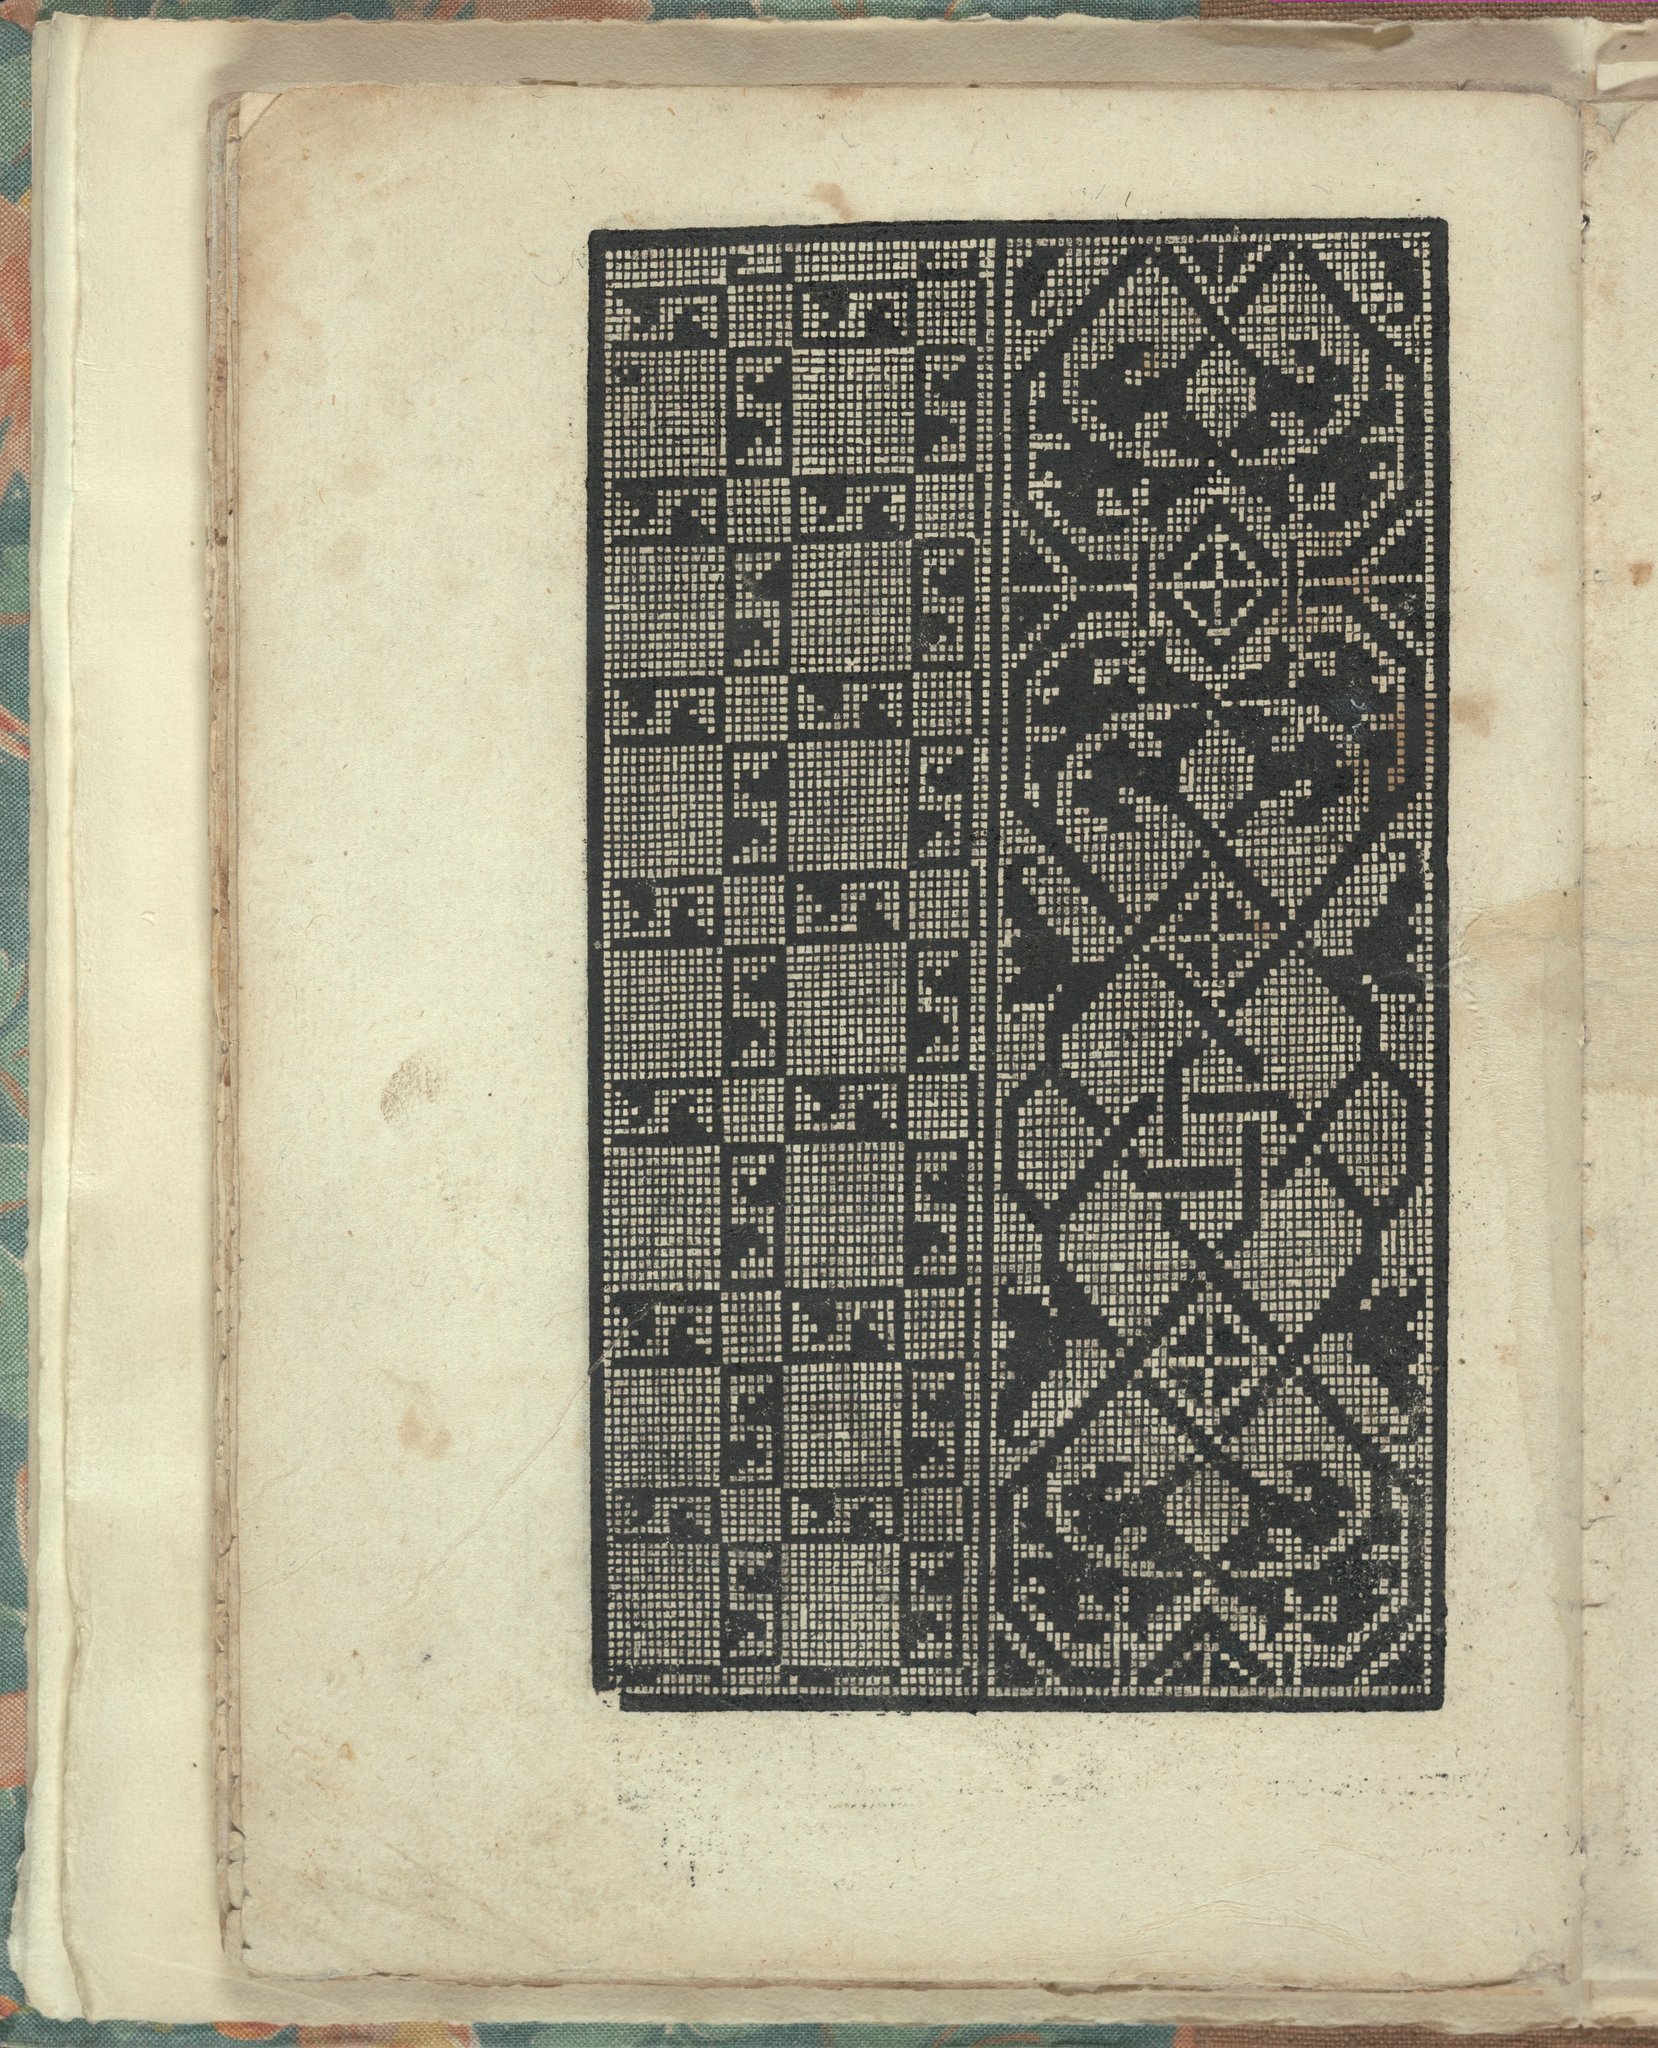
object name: book print ornament architecture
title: Opera Nova Universali intitulata Corona di racammi, page 33 (verso)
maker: giovanni andrea vavassore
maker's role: publisher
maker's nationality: italian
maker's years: 1530-1573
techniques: woodcut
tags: ornament